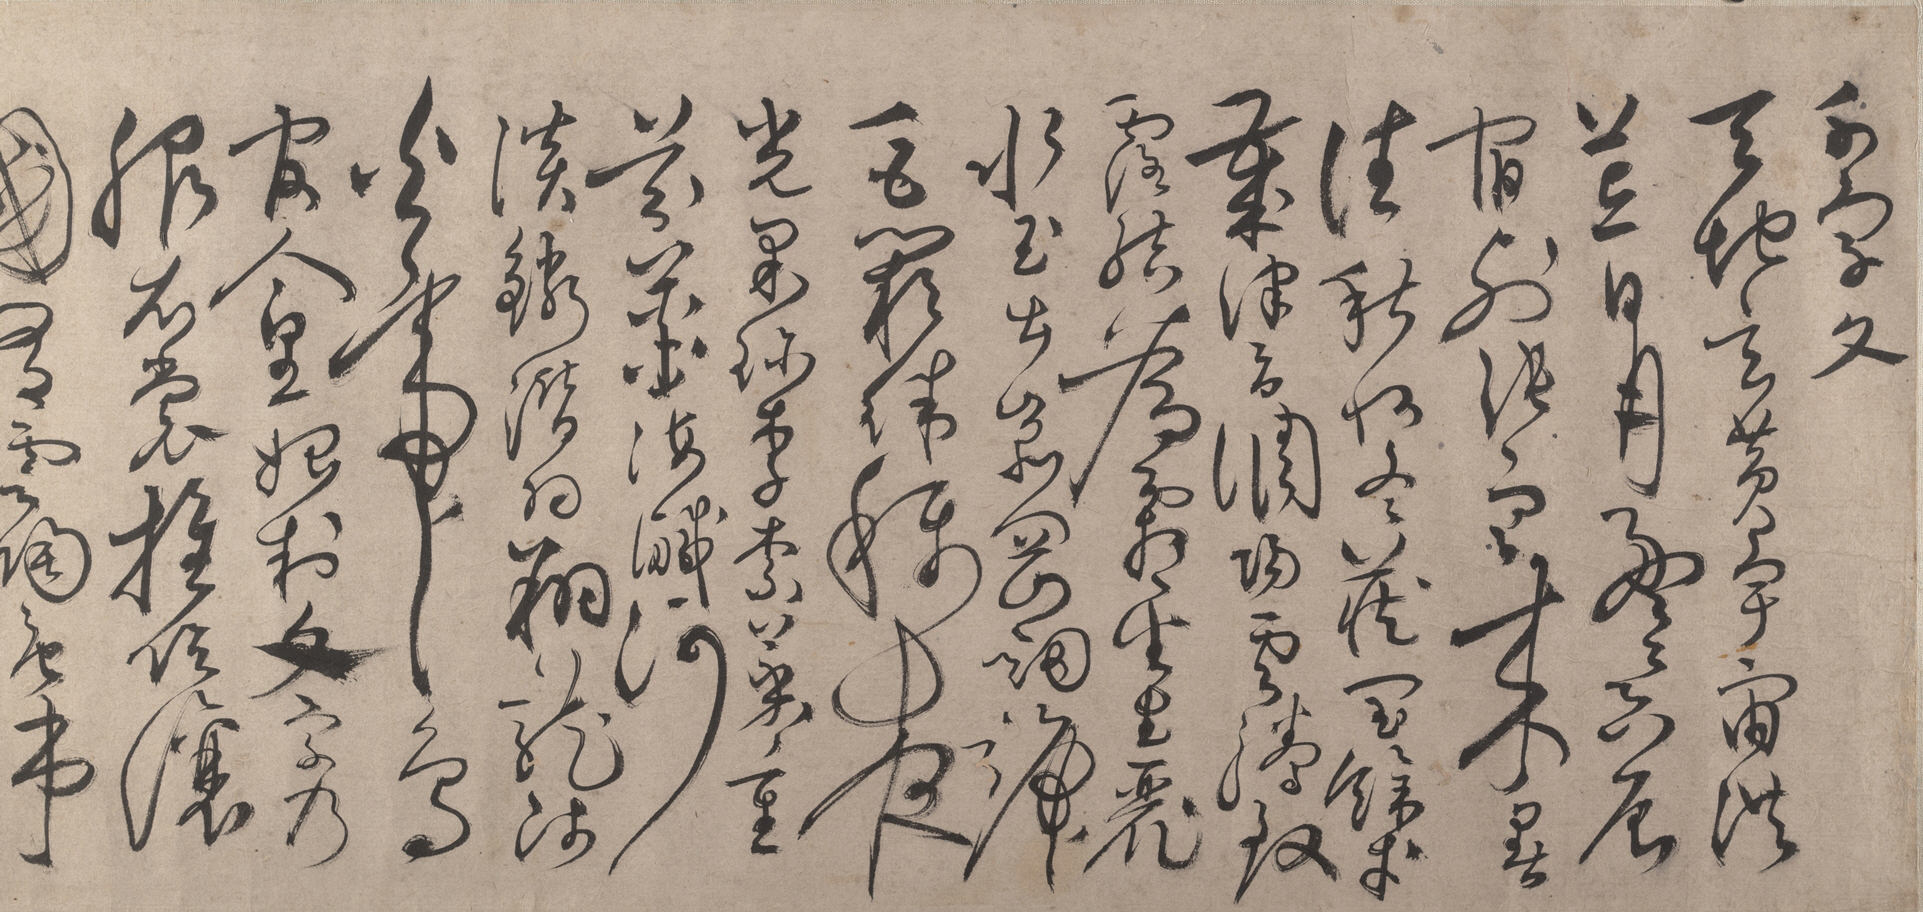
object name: handscroll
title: Thousand Word Classic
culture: chinese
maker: zhang bi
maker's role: artist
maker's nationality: chinese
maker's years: 1425-1487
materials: ink, paper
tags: calligraphy